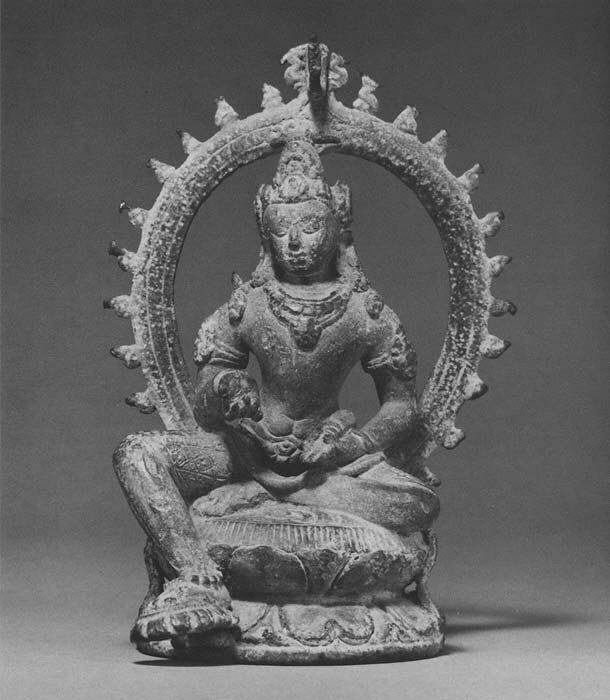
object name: figurine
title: Seated Bodhisattva Vajrasattva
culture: indonesian, javanese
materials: bronze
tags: buddhism,bodhisattvas